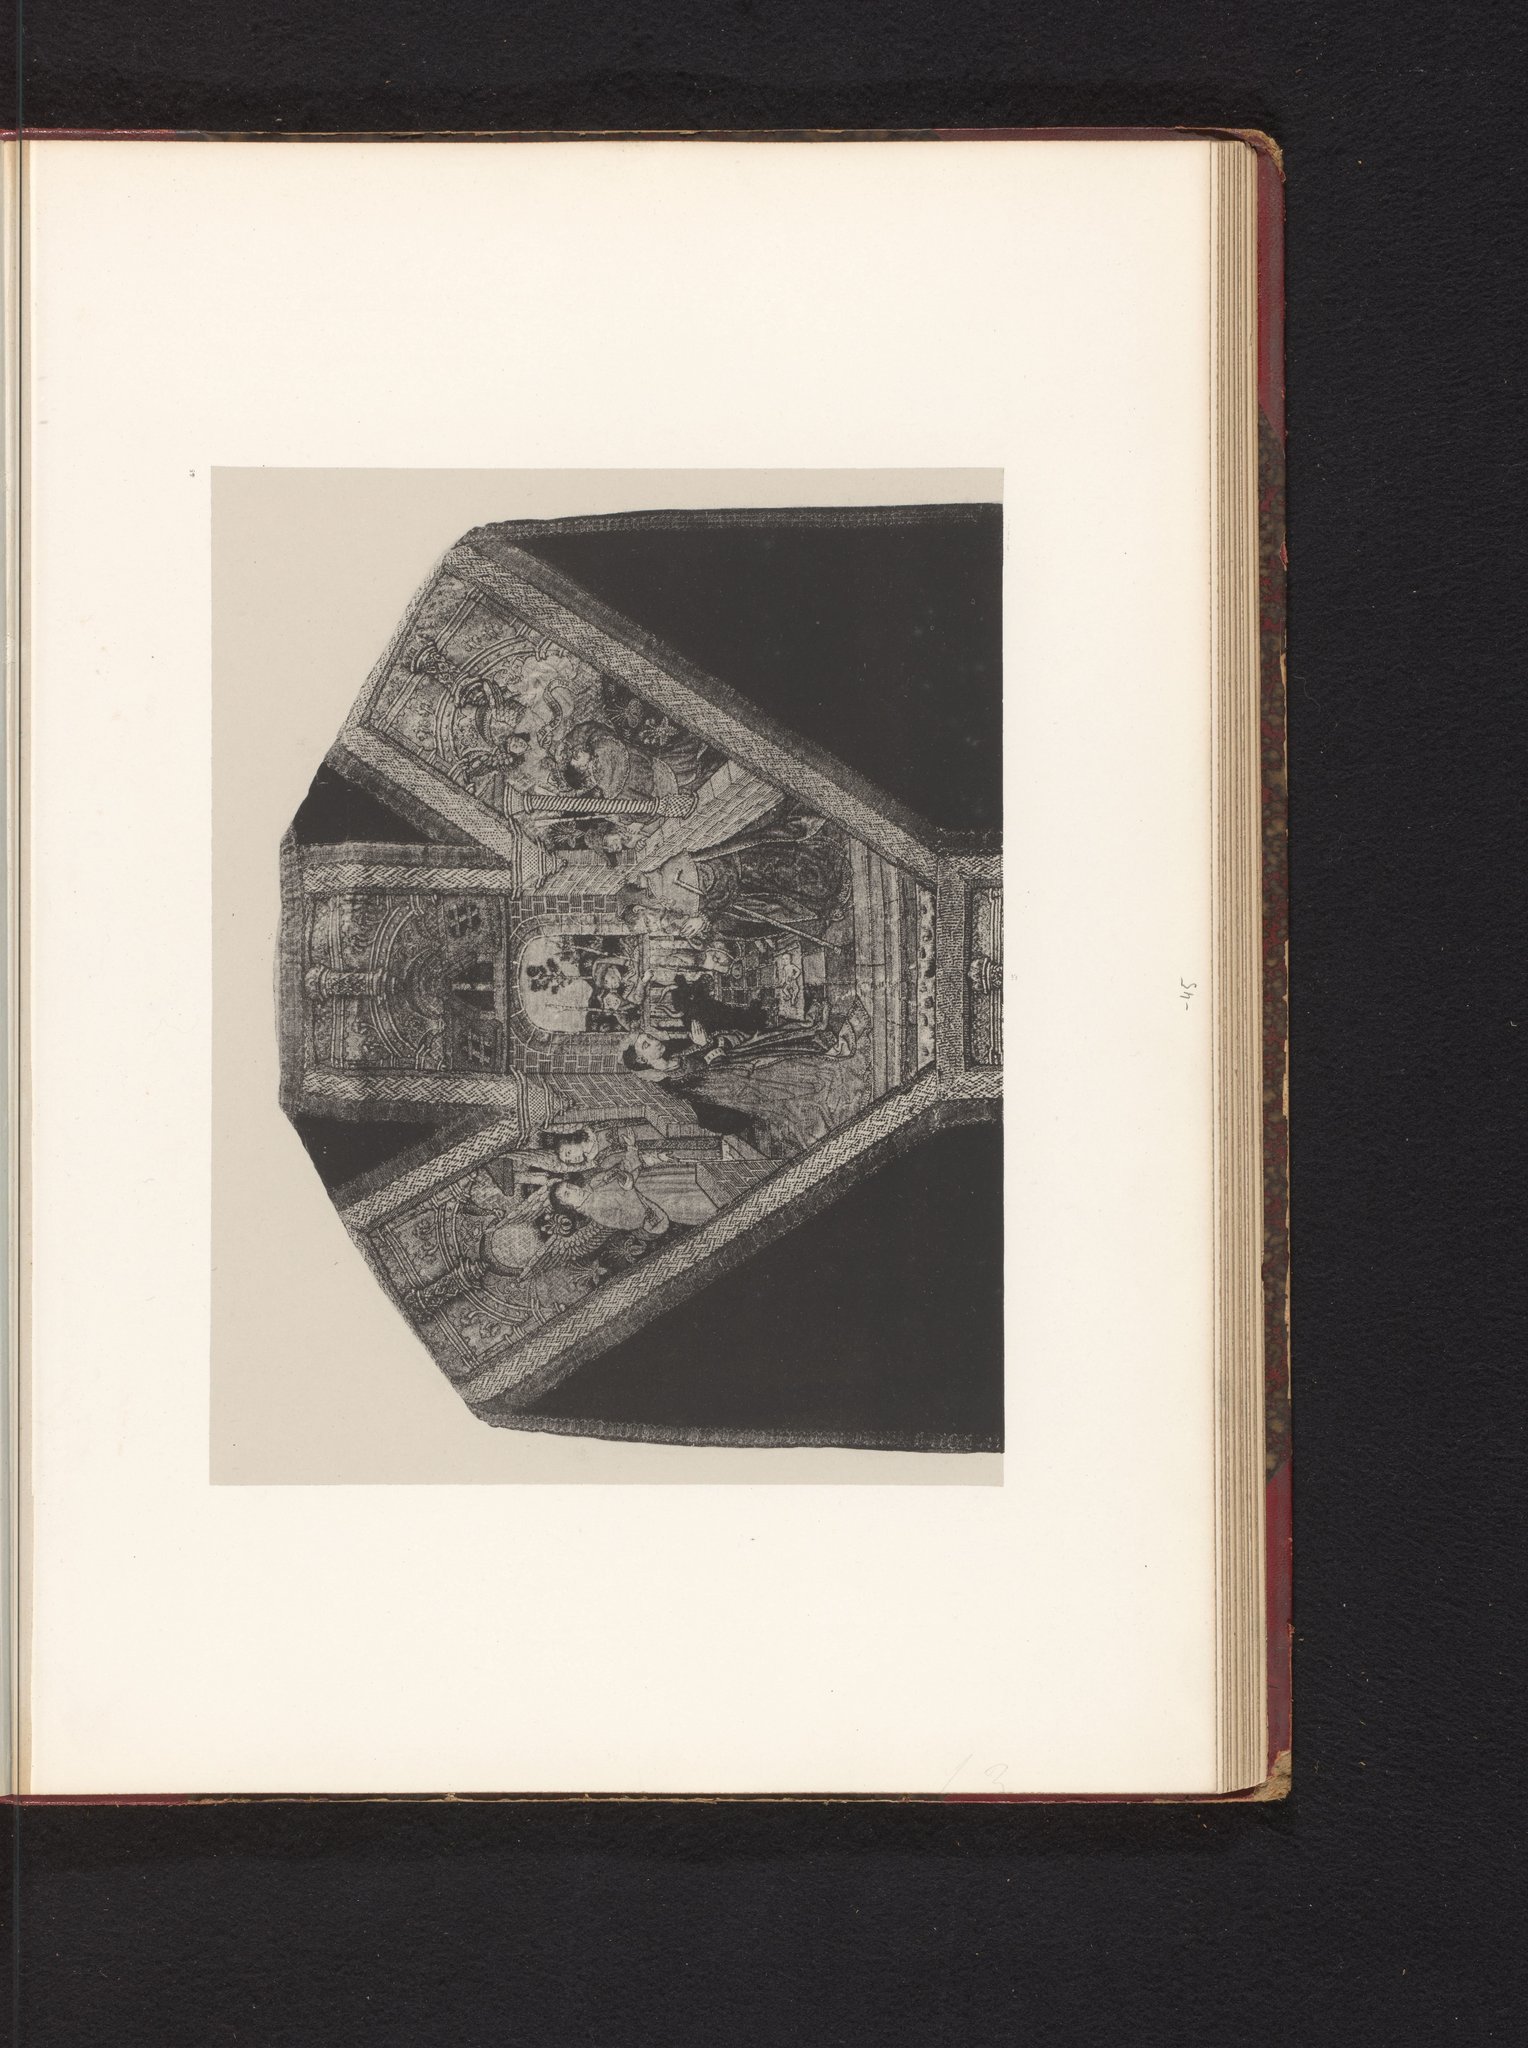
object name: page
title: Kazuifel uit een kerk in Lier, opgesteld op een tentoonstelling over religieuze objecten uit de middeleeuwen en renaissance in 1864 in Mechelen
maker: joseph maes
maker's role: fotograaf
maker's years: 1838-1908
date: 1864-1866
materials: paper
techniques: photolithography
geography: mechelen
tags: chasuble, mechelen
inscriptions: number: ‘13’, number: ‘13’, number: ‘-45’